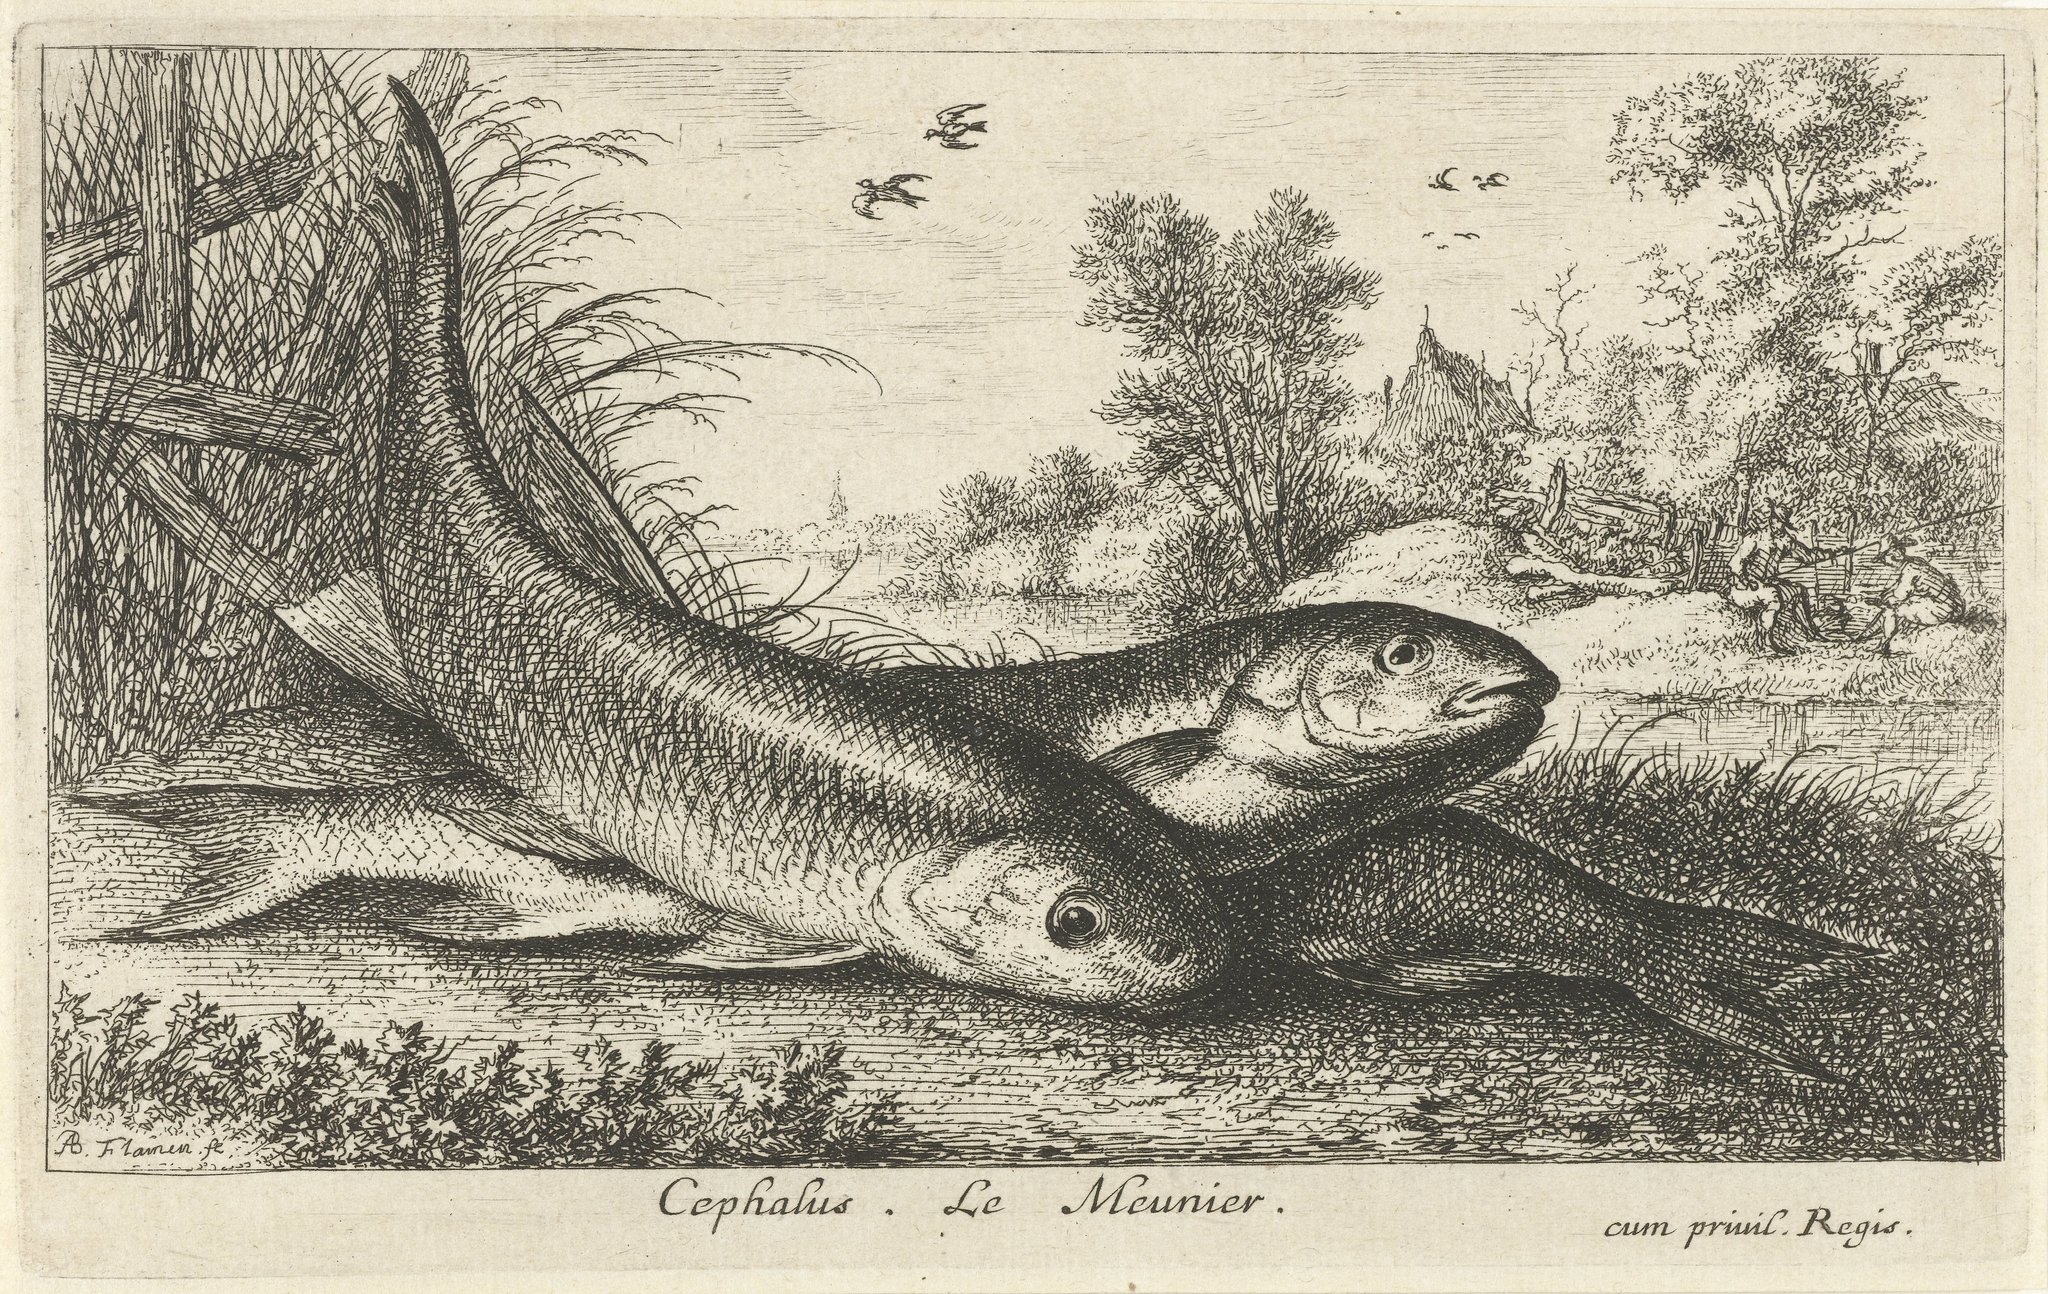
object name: print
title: Diverses Especes de Poissons d'eau douce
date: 1664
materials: paper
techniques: etching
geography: paris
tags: fishes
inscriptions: collector's mark: Lugt 2228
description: In het gras langs een rivier liggen drie vissen. Op de achtergrond twee vissers op de rivieroever.